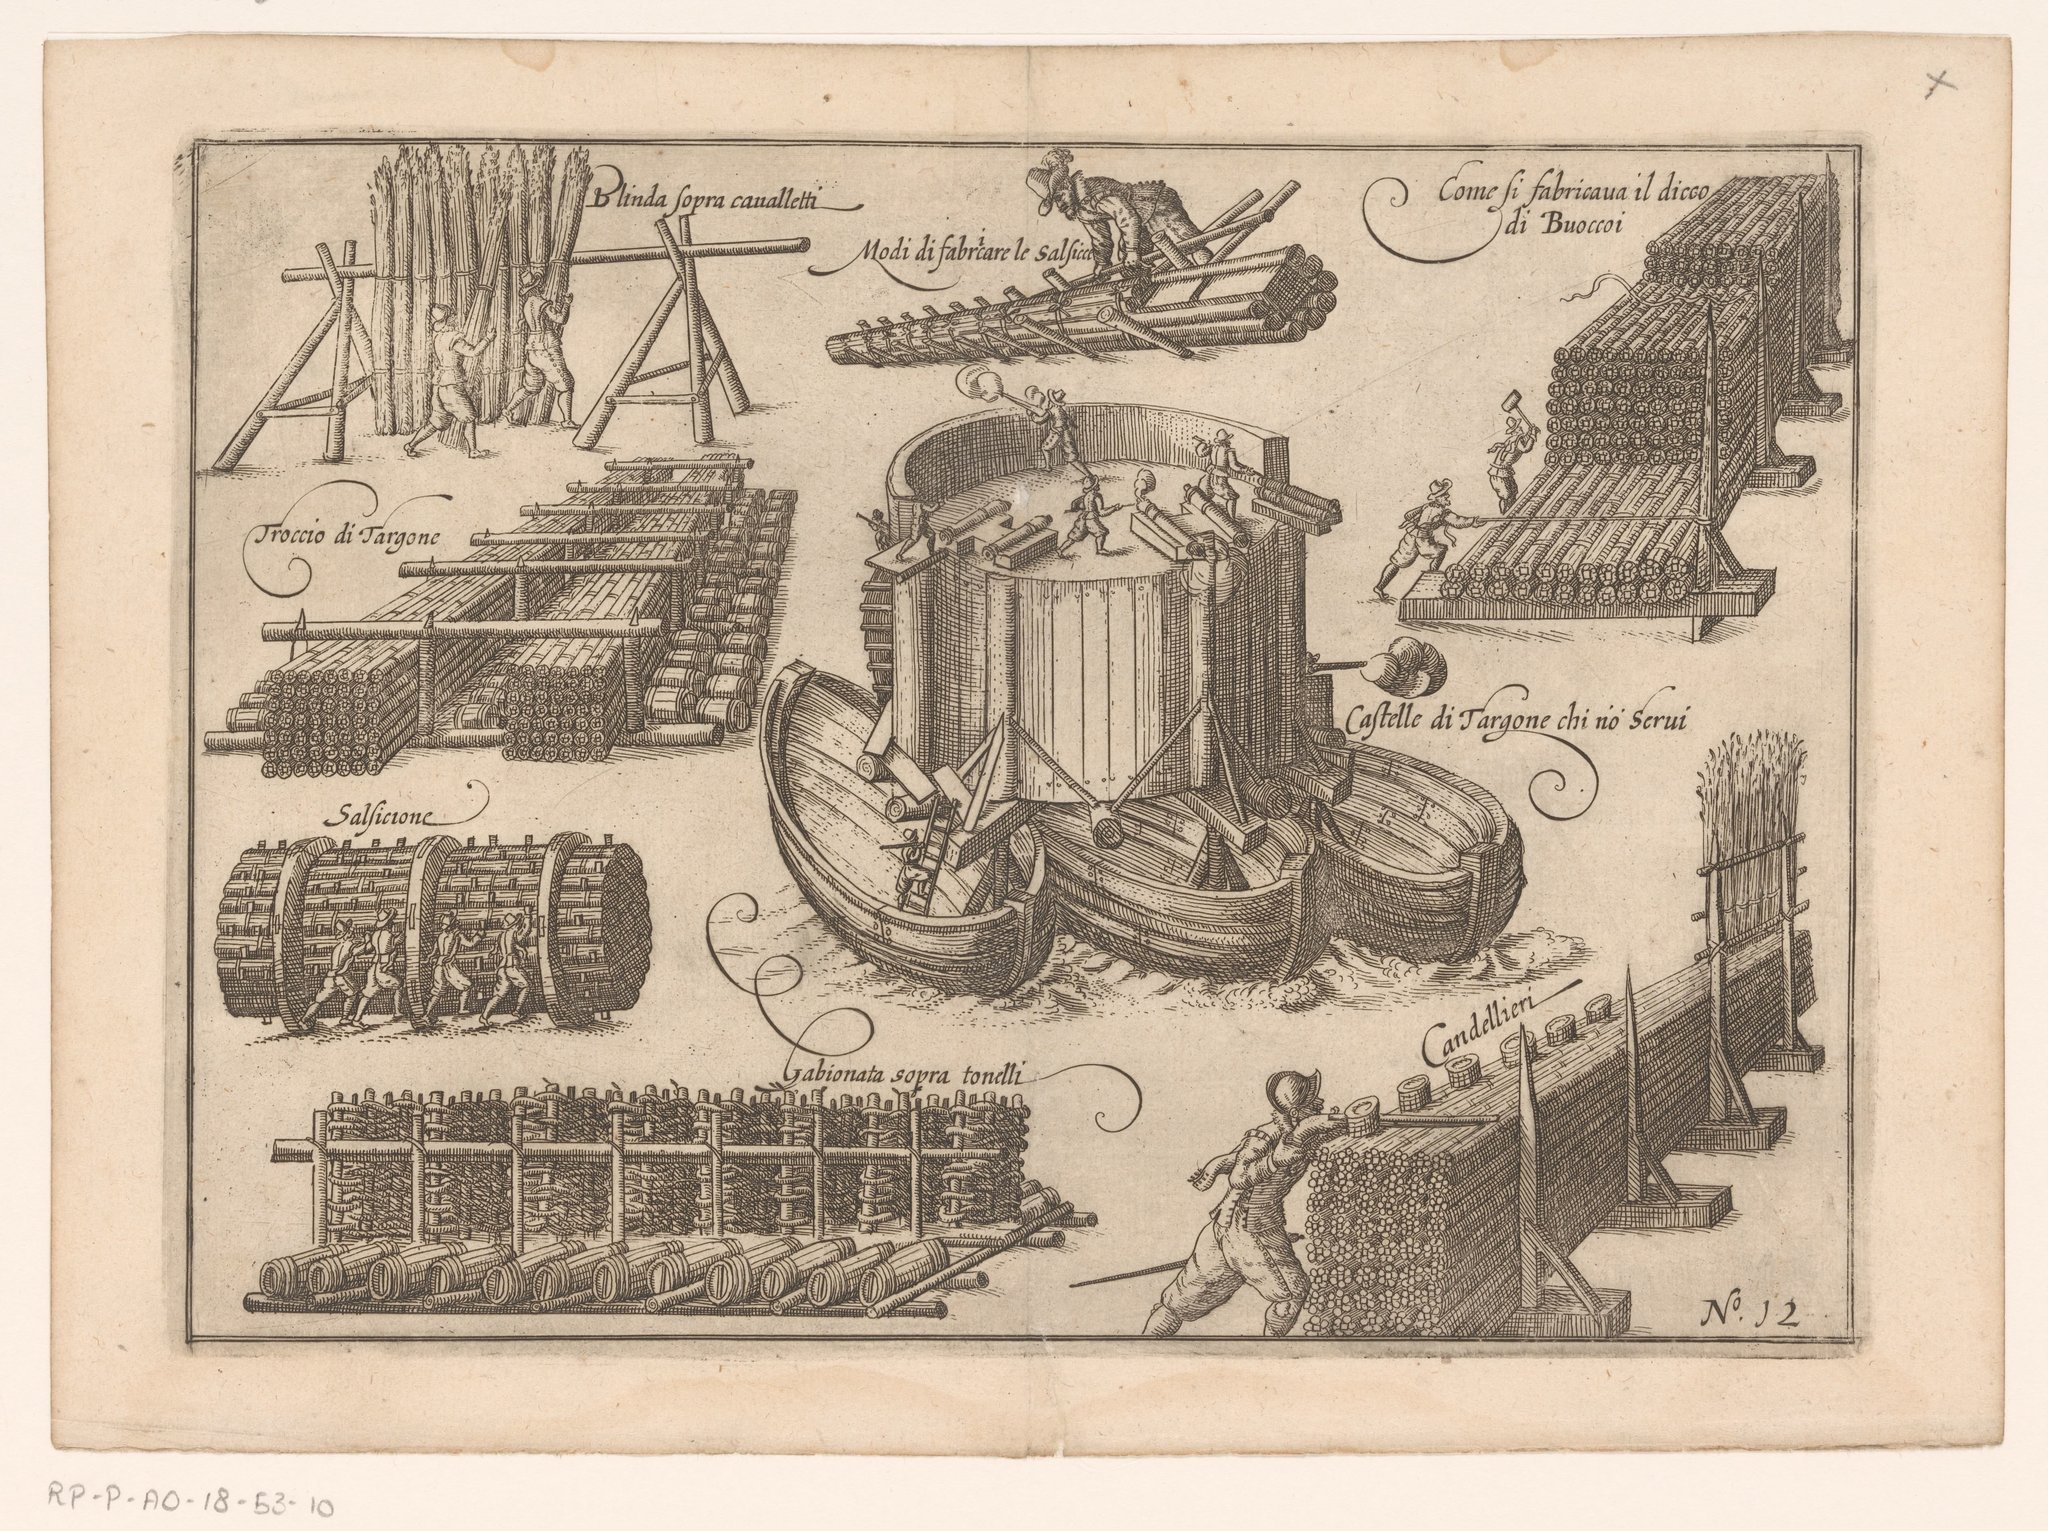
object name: print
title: Beleg van Oostende: belegerings- en aanvalstuigen van Targone, 1603-1604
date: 1615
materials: paper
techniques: etching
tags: pompeo targone, siege arms, e.g.: battering ram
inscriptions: collector's mark: Lugt 2228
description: Kopie naar de prent in: Giustiniano, Pompeo. Delle guerre di Fiandra libri VI. Antwerpen: Joachim Trognesius, 1609. Niet gebruikt in de contemporaine journalen van het beleg van Oostende uit 1604 (exemplaren in de collectie van de Rijksmuseum Research Library (326 F 10 en 326 F 11). Eerdere staat van prent ook gebruikt in Haestens, Hendrick van. De Bloedige ende strenge Belegeringhe Der Stadt Oostende in Vlaenderen. Leiden: Hendrick van Haestens, 1613. Huidige staat van prent ook gebruikt in: H. Haestens, La nouvelle Troye ou memorable histoire du siege d’Ostende, Leiden 1615.